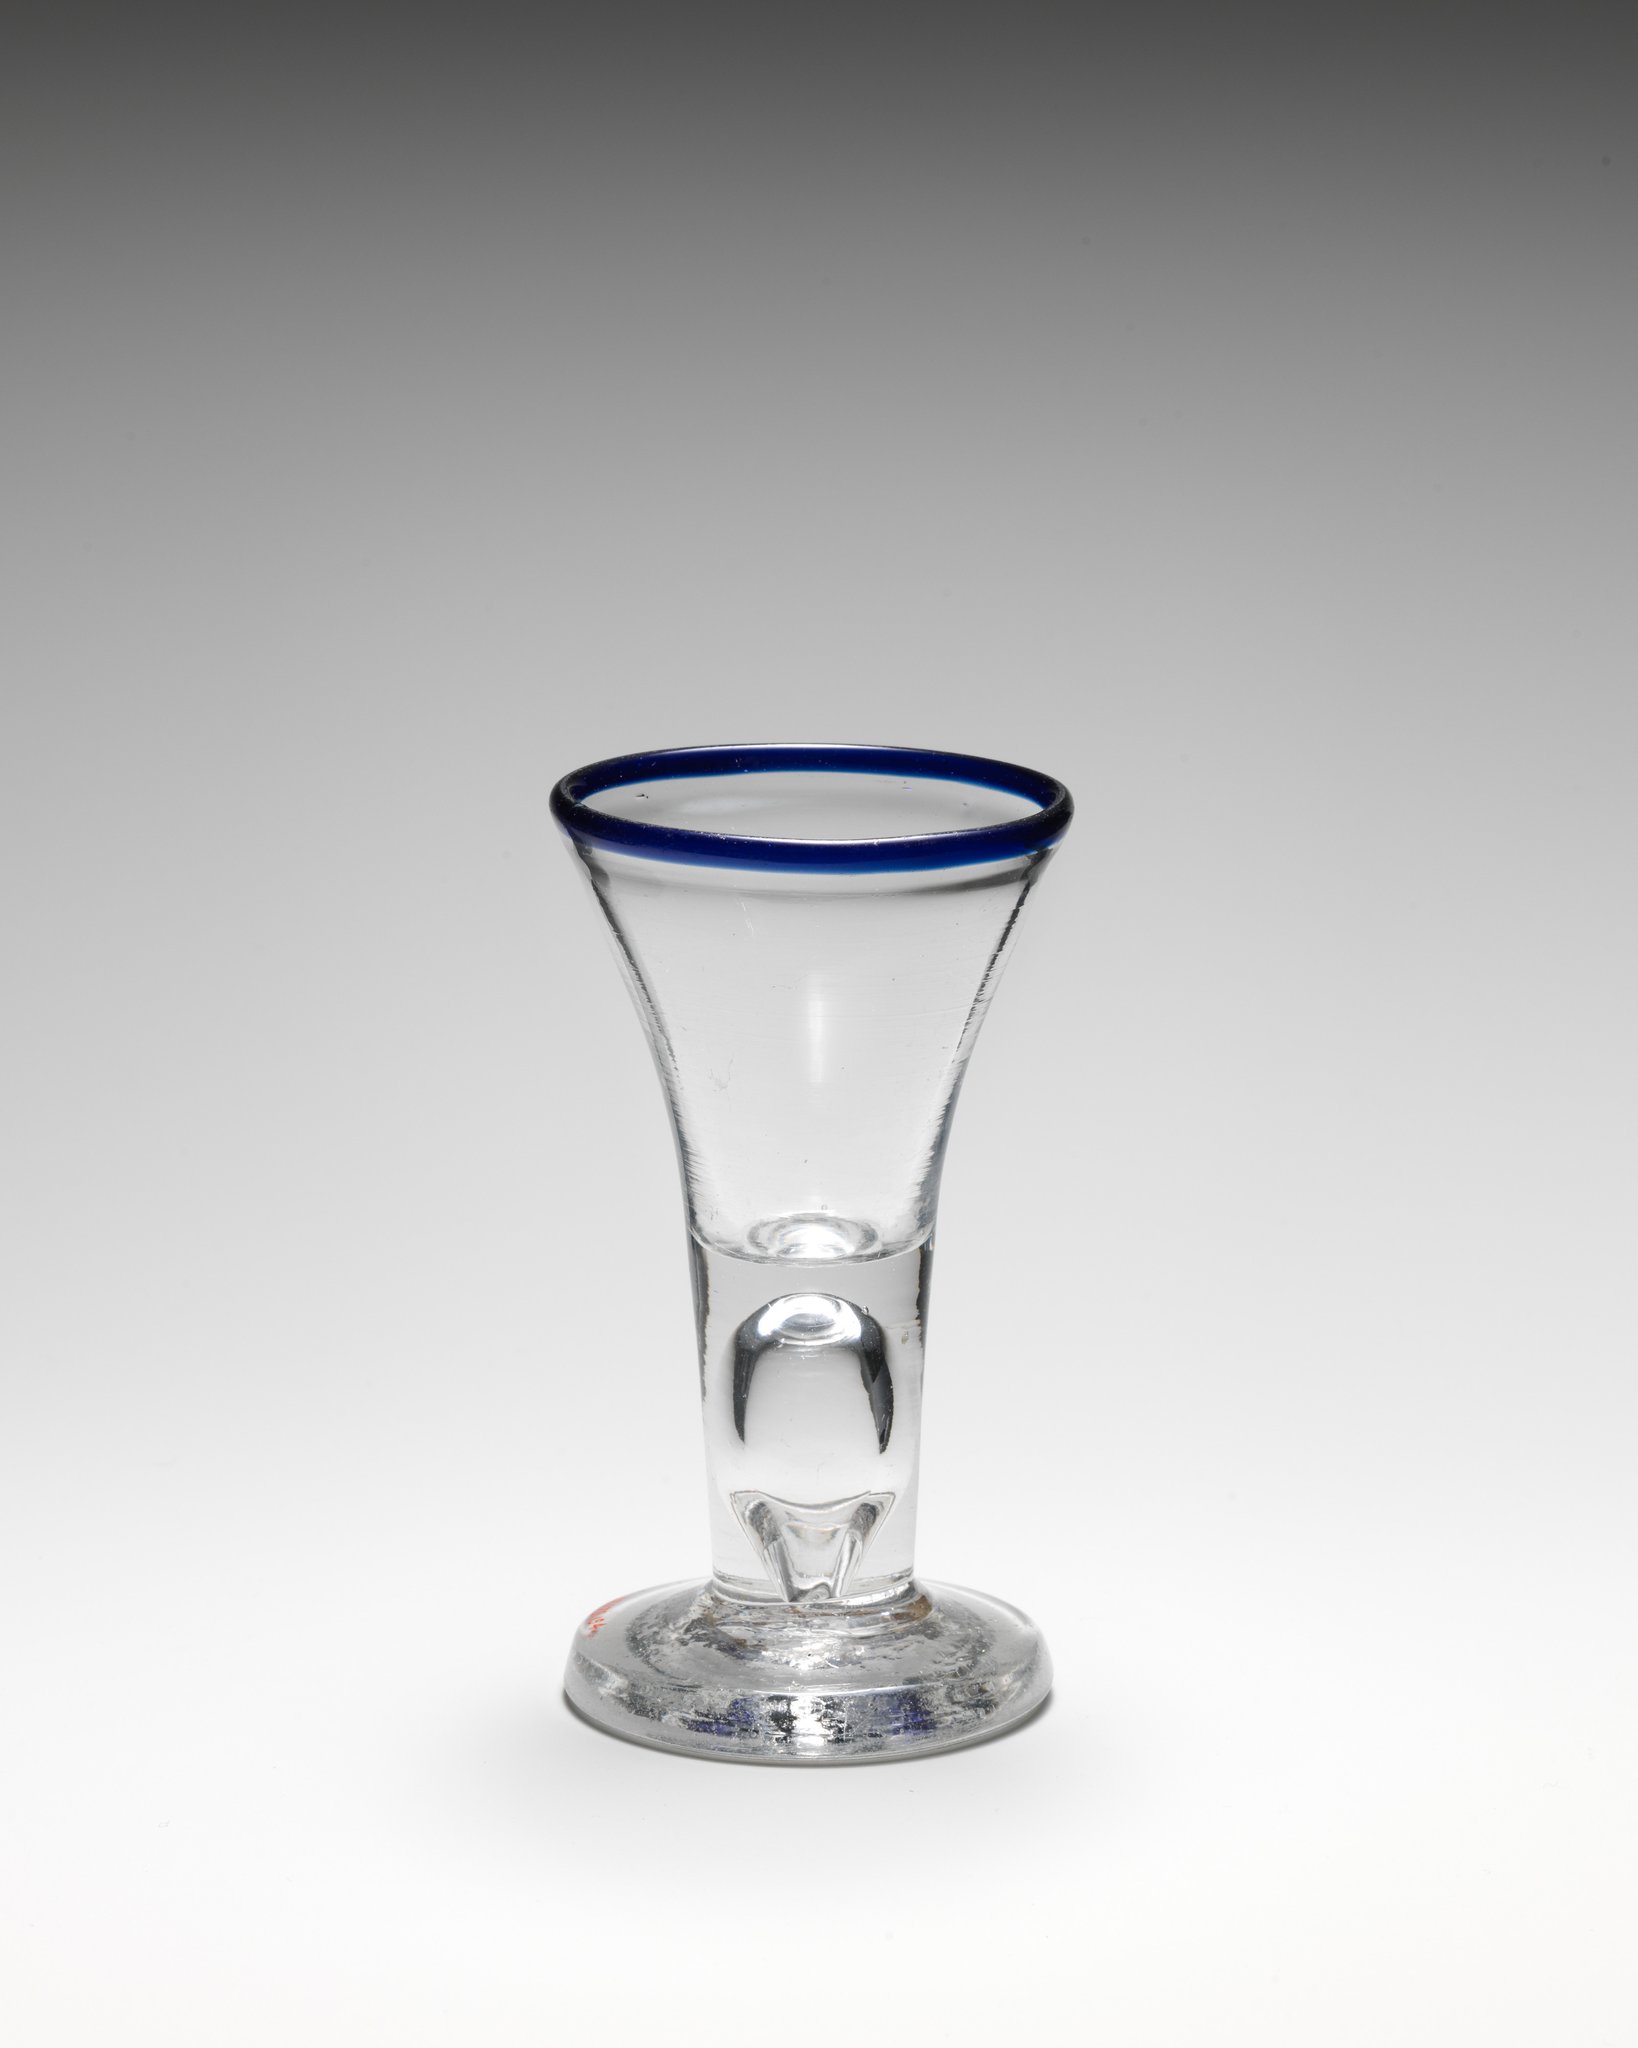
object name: firing glass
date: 1701-1800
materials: glass